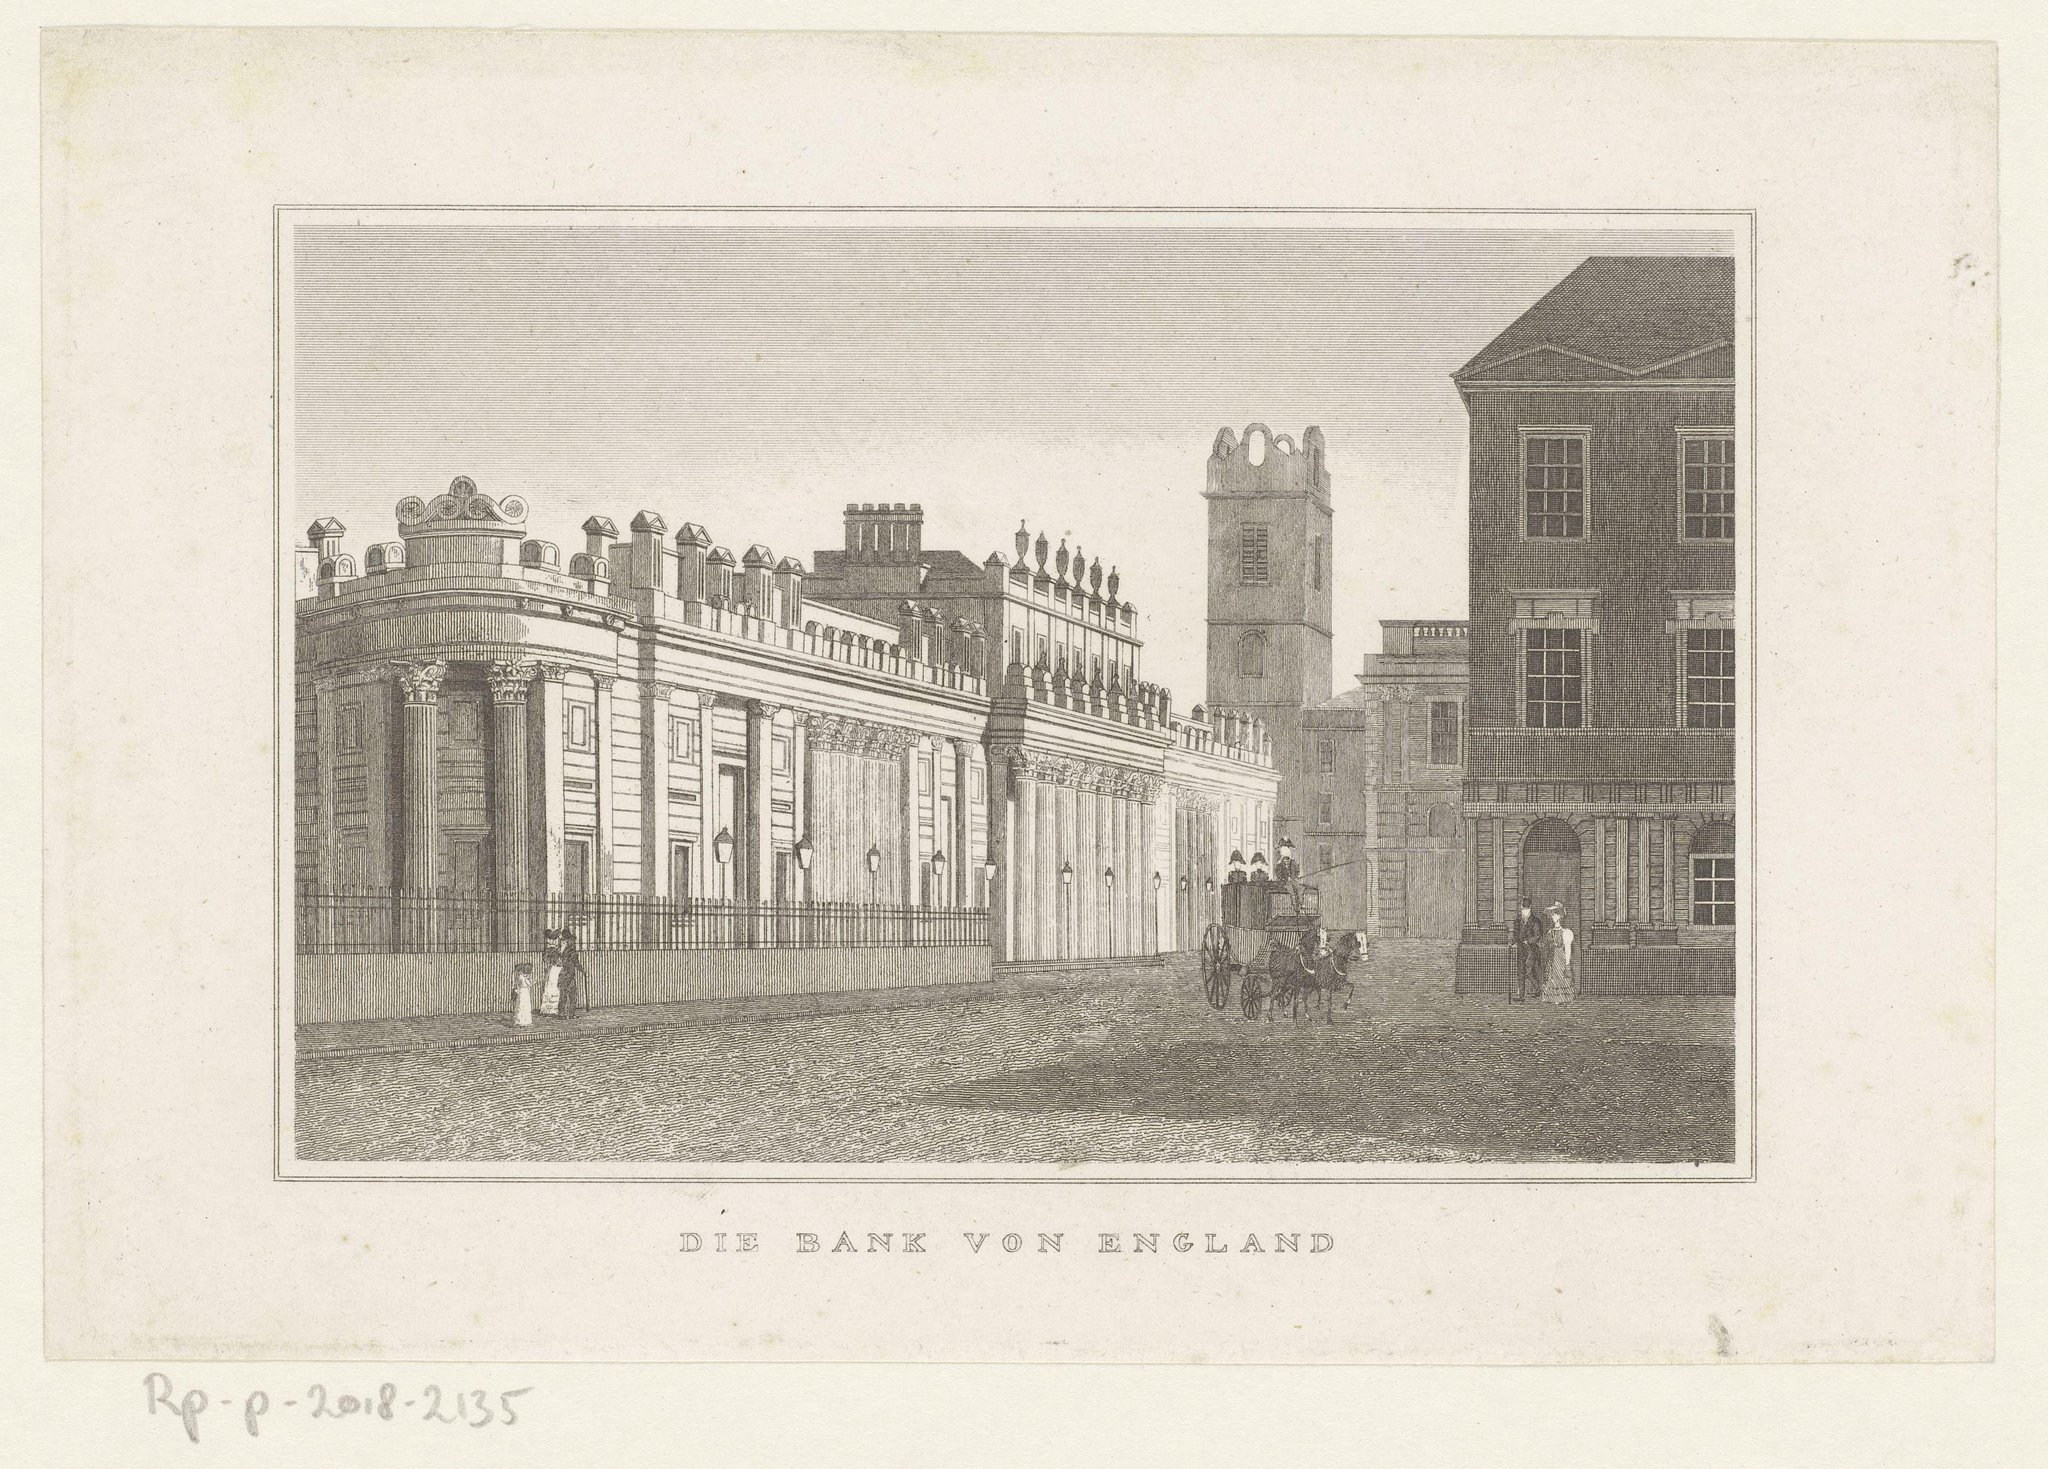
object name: print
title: Die Bank von England in London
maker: Anonymous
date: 1828-1874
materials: paper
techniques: engraving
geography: hildburghausen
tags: bank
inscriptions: collector's mark: Lugt 2228